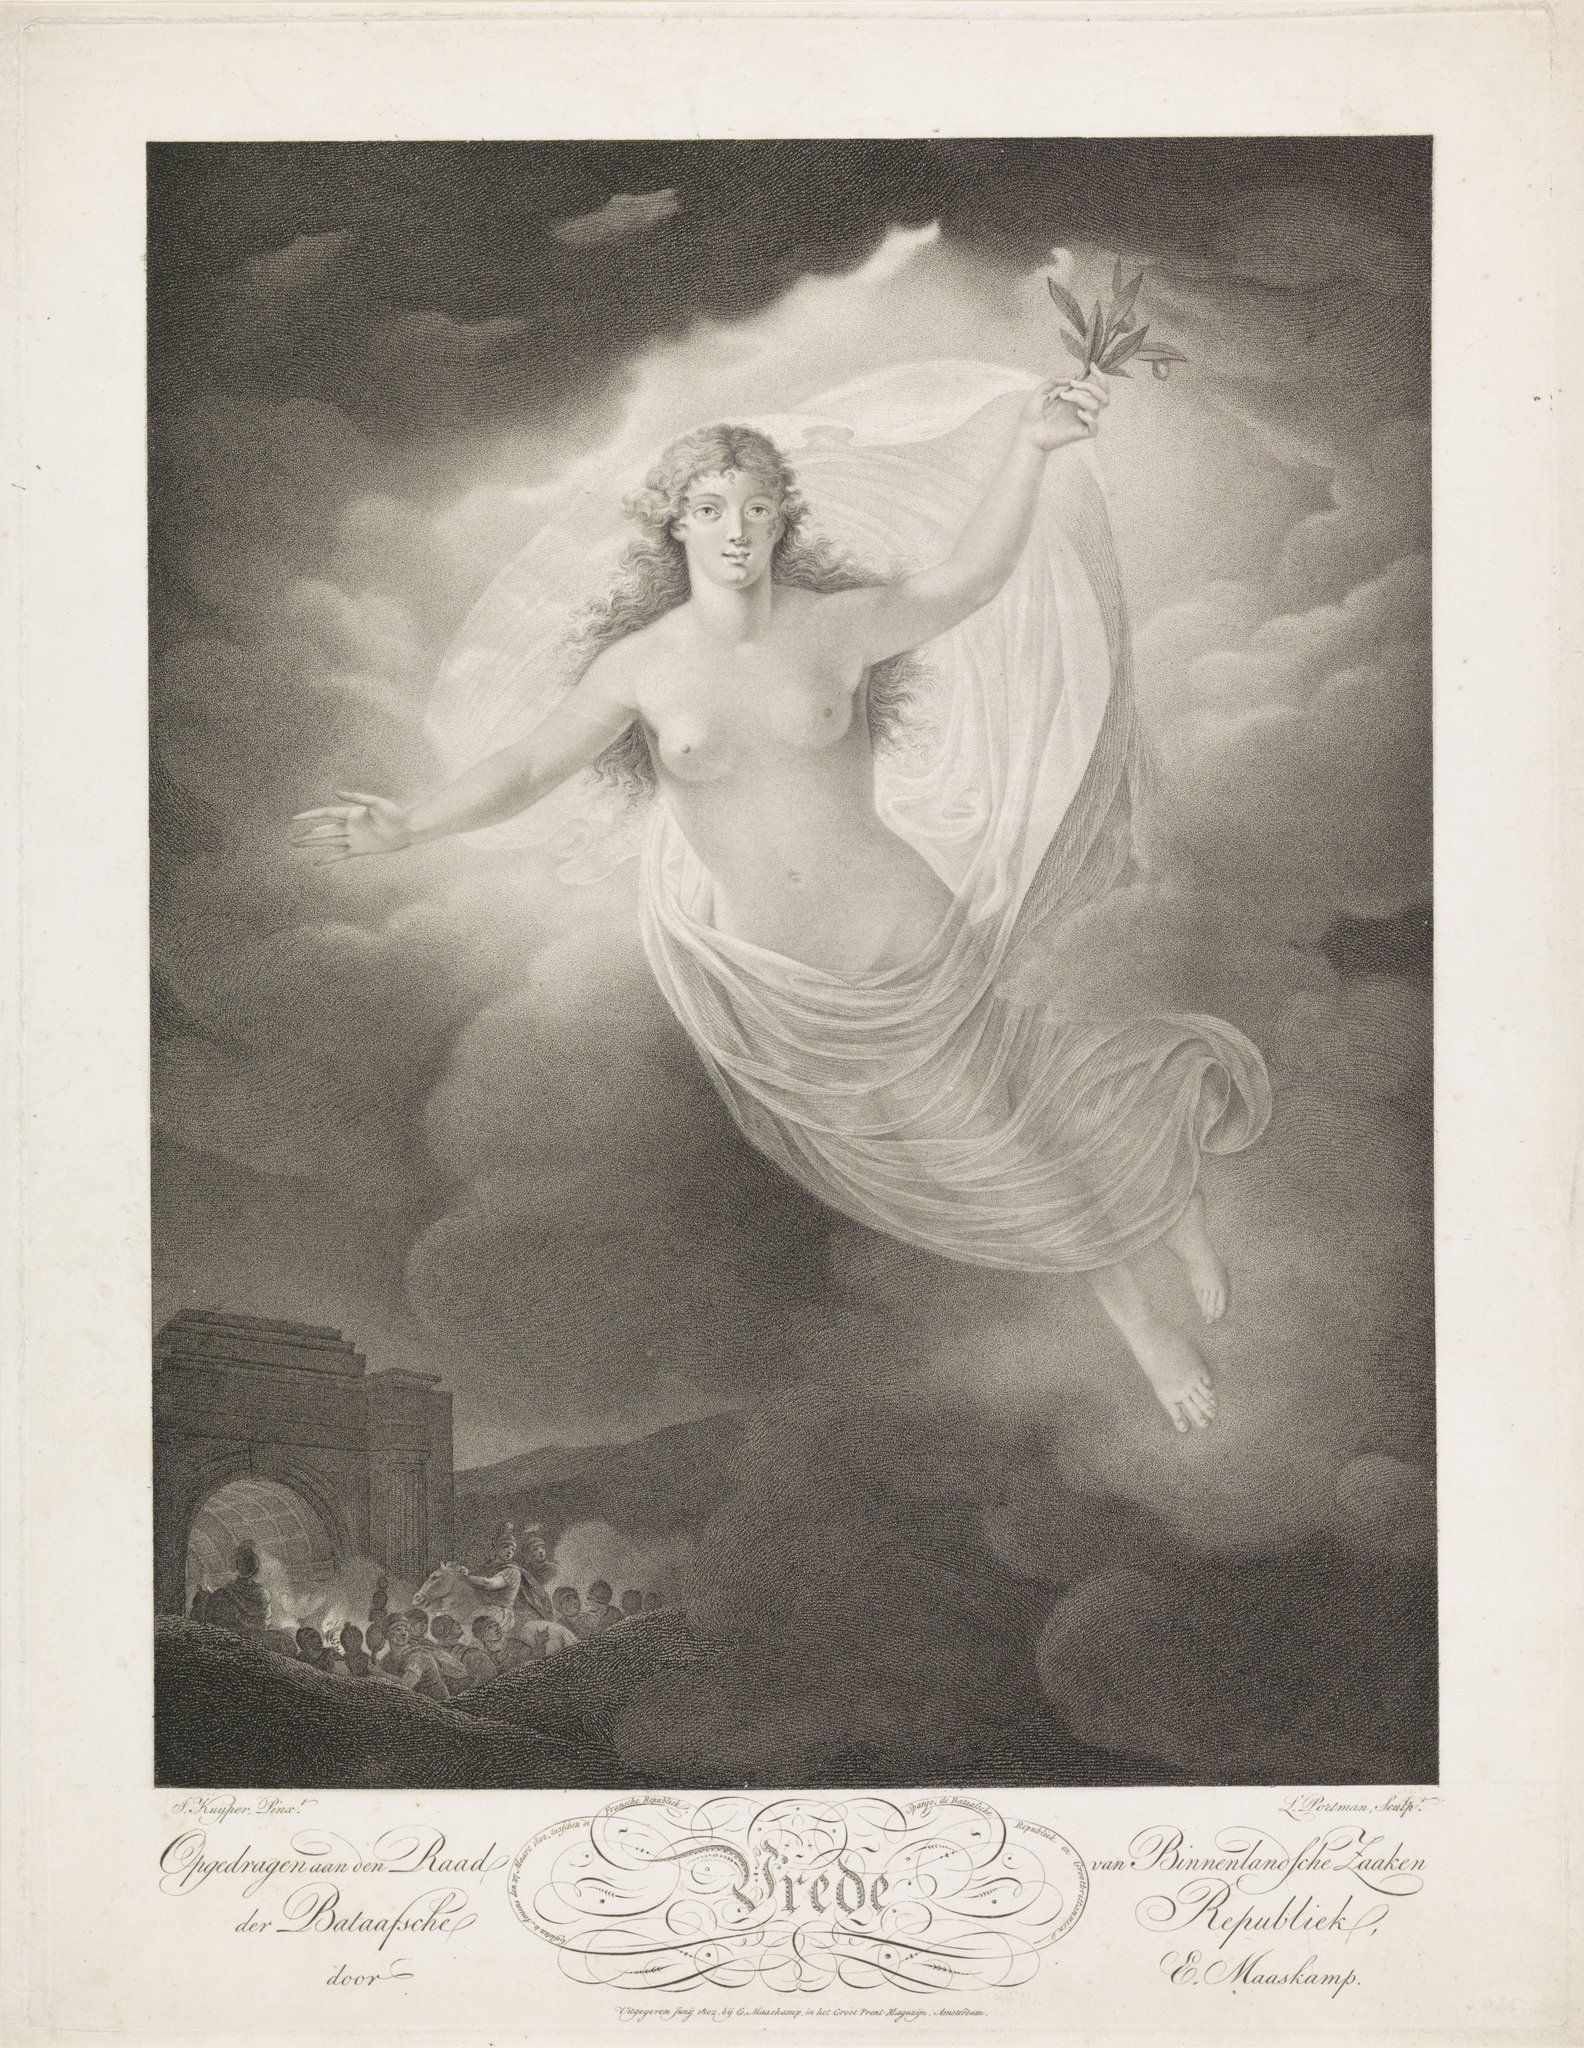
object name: print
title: Allegorie op de Vrede van Amiens, 1802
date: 1802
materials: paper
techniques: engraving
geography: amsterdam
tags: symbols, allegories of peace, 'pax'; 'pace' (ripa), conqueror triumphing, triumphal entry of victor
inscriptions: collector's mark: Lugt 2228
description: Allegorie op de Vrede van Amiens, op 27 maart 1802, die een einde maakte aan de oorlog tussen Groot-Brittannië en de Franse republiek, Spanje en de Bataafse Republiek. Centraal zweeft de Vrede door de wolken met een olijftak in de hand. Linksonder keert het afgematte leger terug binnen de vesting. Bij de prent behoort een verklaring. Zie ook de pendant.